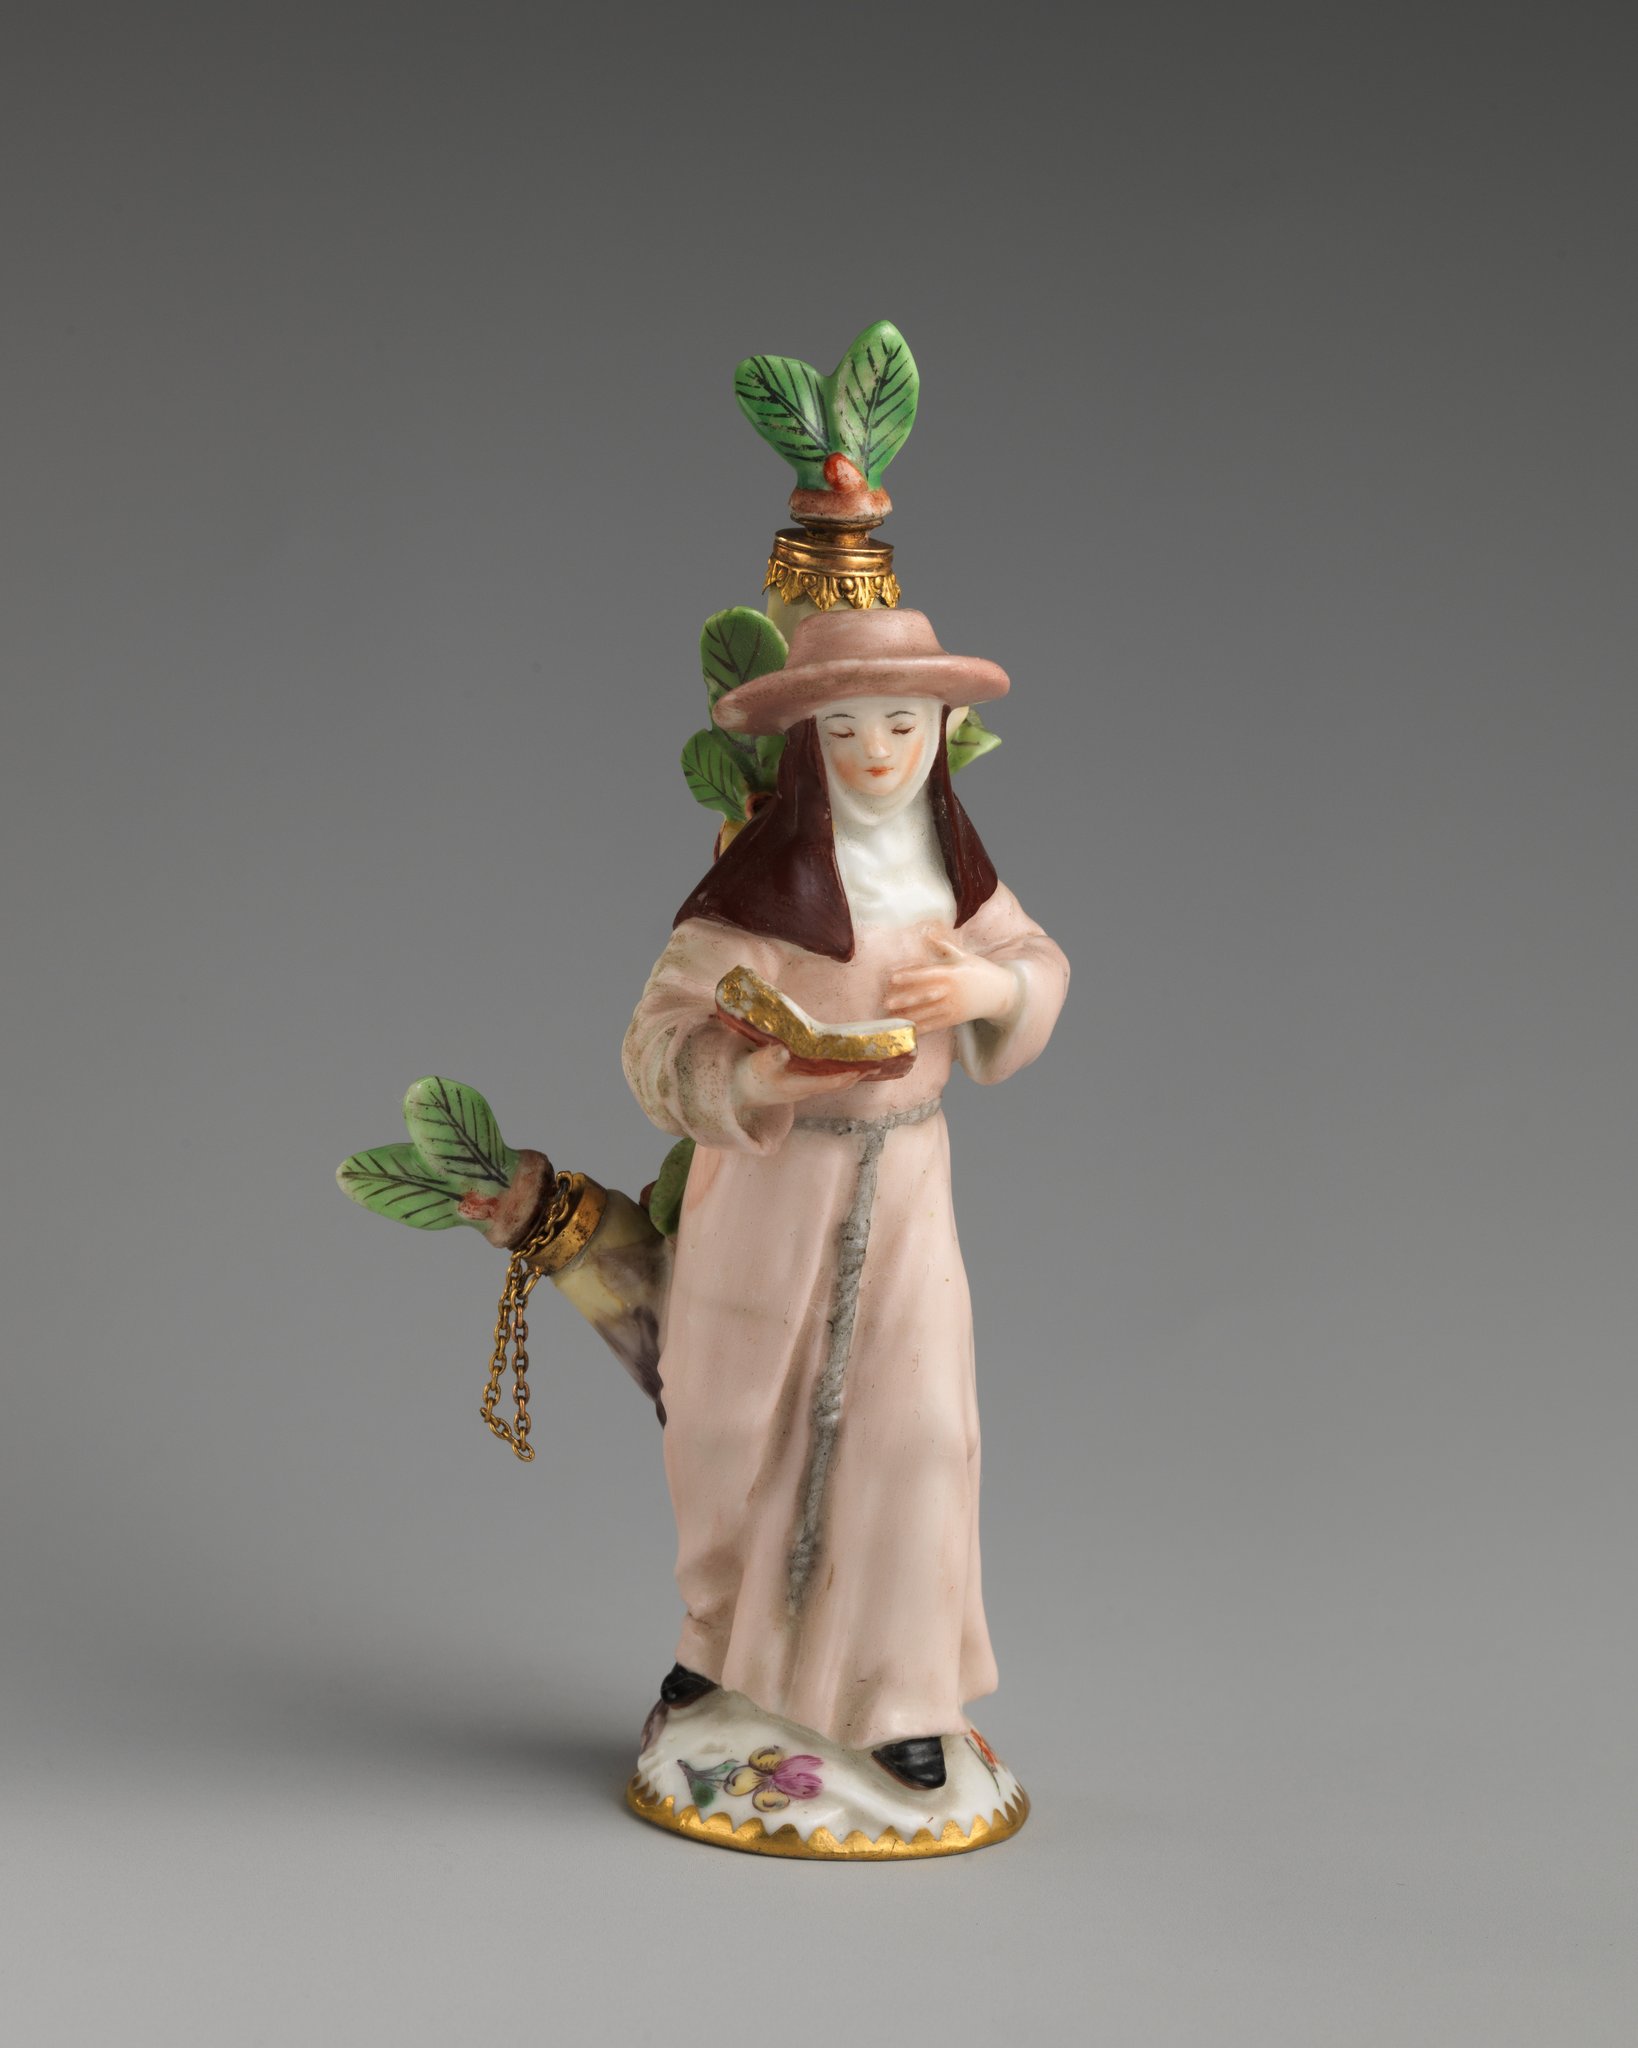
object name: scent bottle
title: Scent bottle in the form of a nun reading a book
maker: chelsea porcelain manufactory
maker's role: factory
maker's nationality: british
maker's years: 1744-1784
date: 1755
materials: soft paste porcelain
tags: books,women,reading,nuns